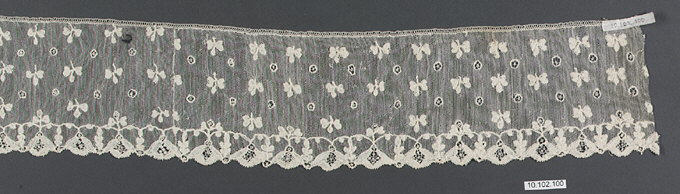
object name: fragment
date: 1701-1800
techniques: lace